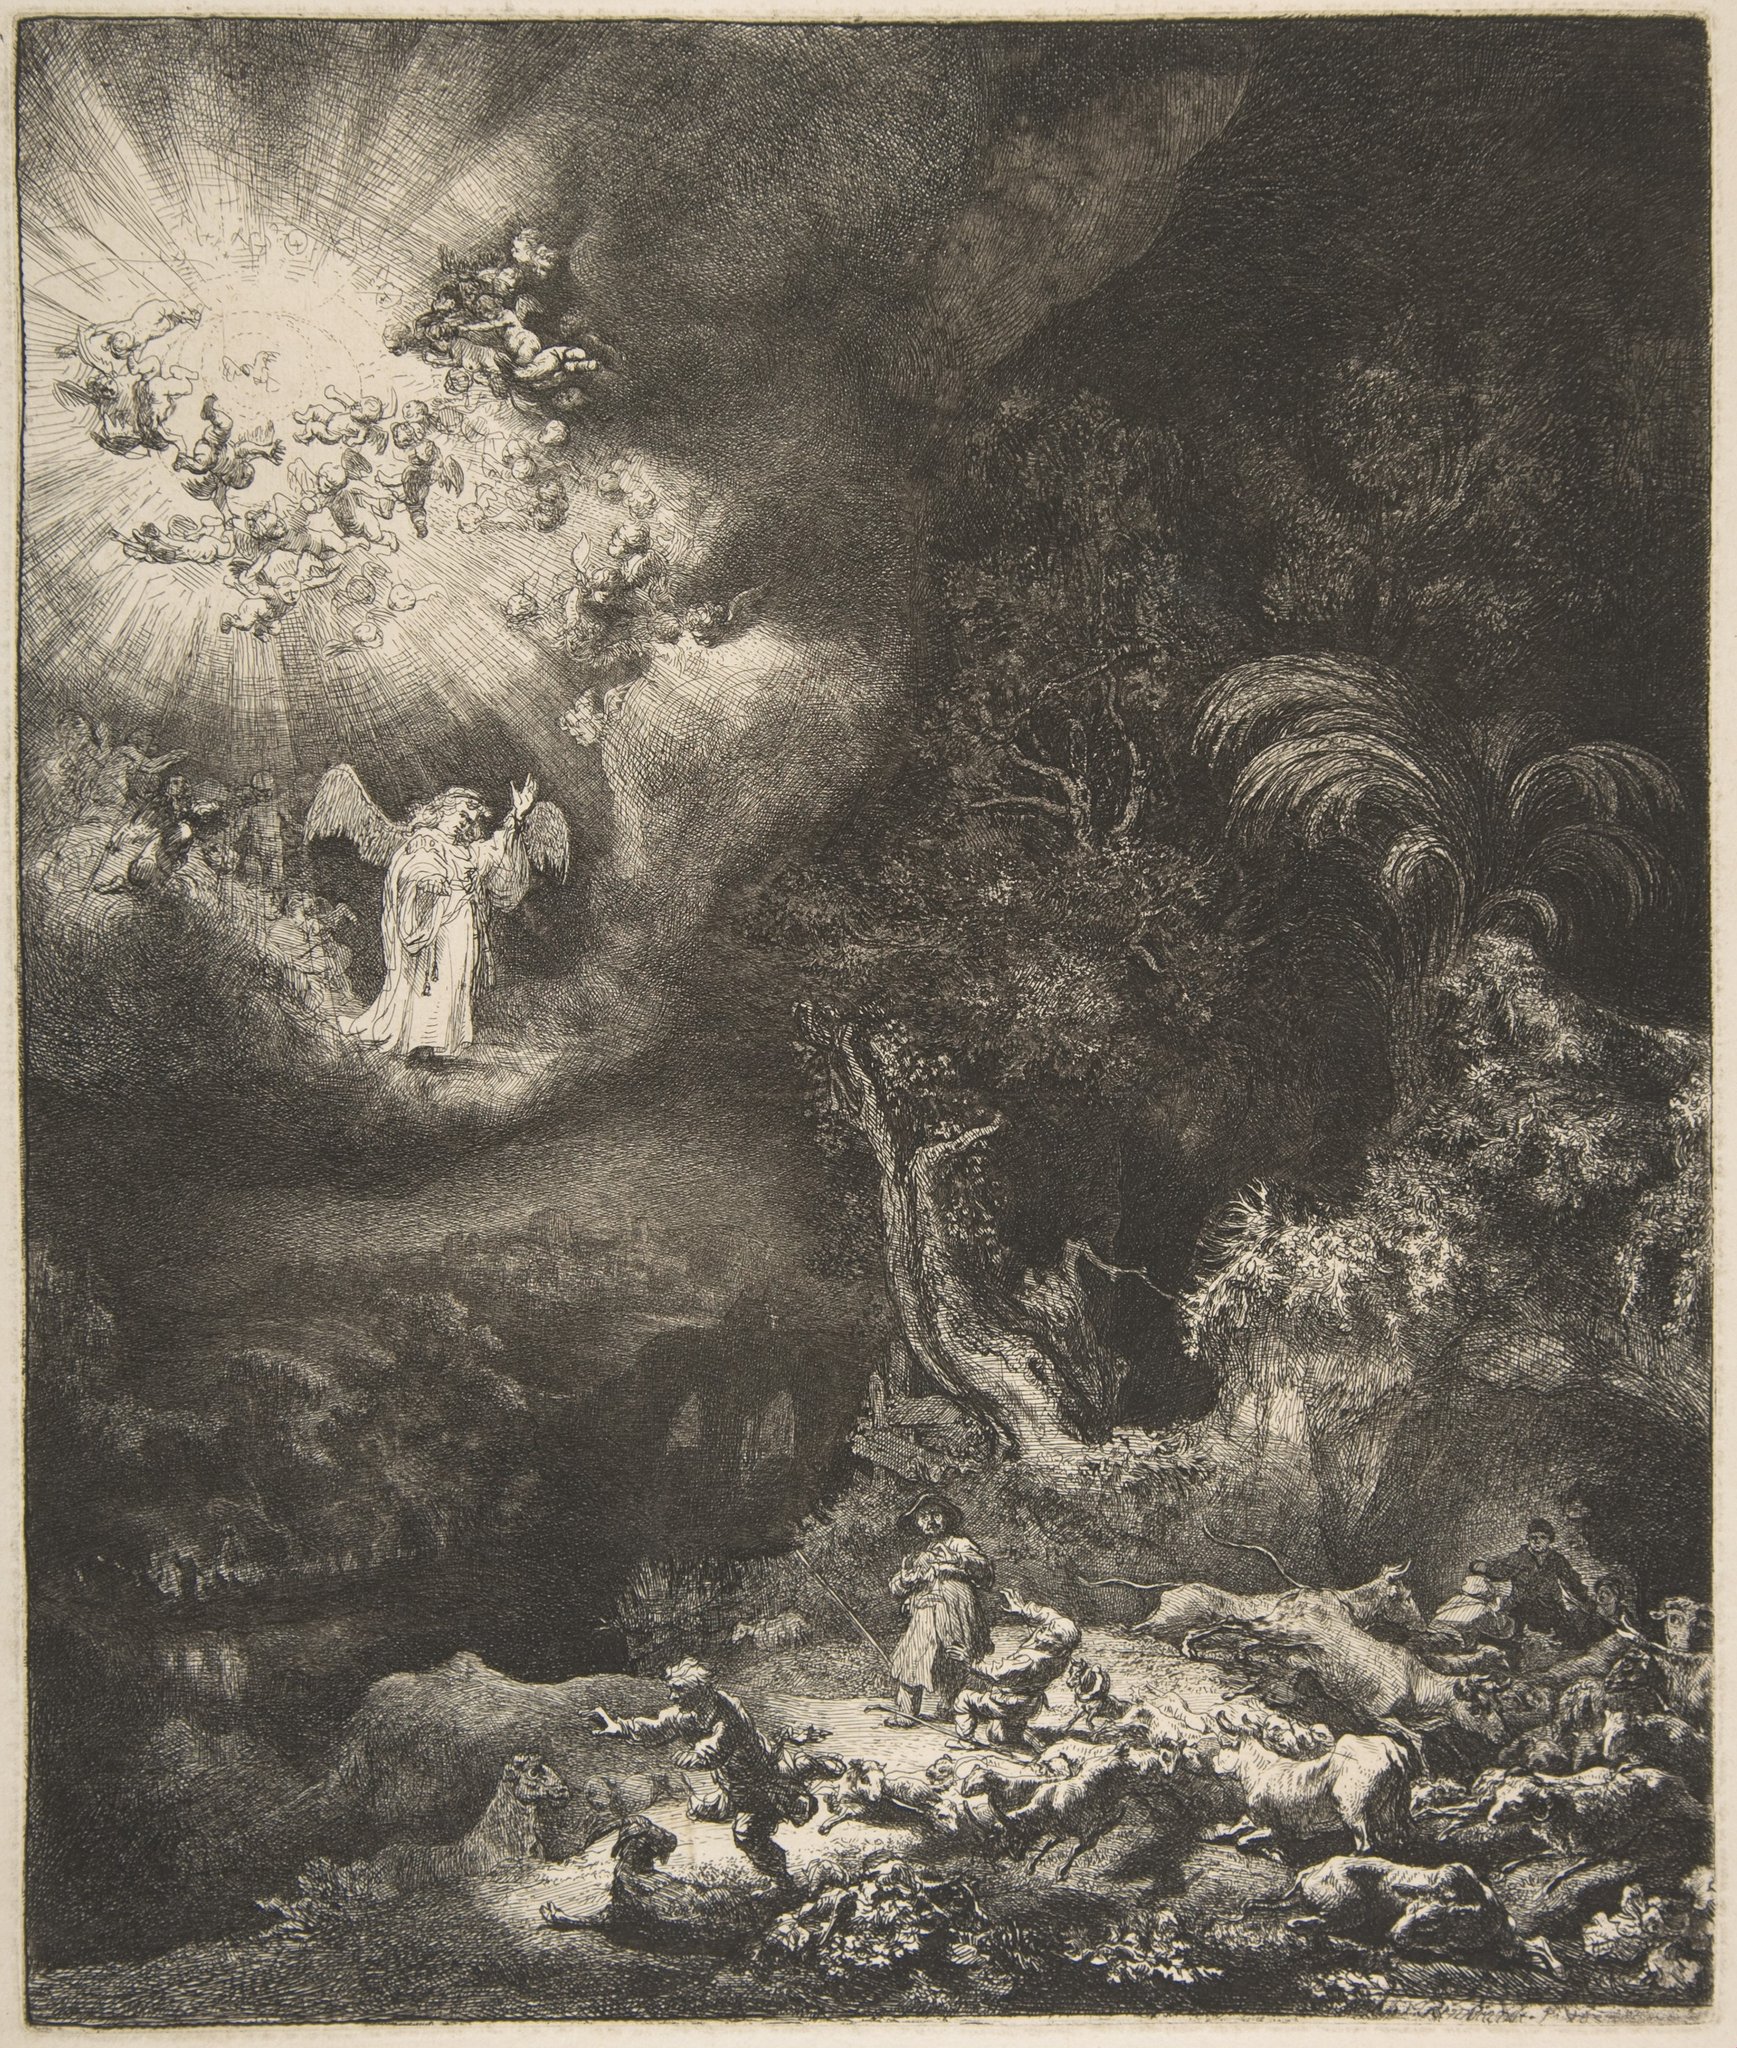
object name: print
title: The Angel Appearing to the Shepherds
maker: rembrandt van rijn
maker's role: artist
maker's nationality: dutch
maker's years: 1606-1669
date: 1634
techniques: drypoint, etching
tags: animals,trees,angels,shepherds